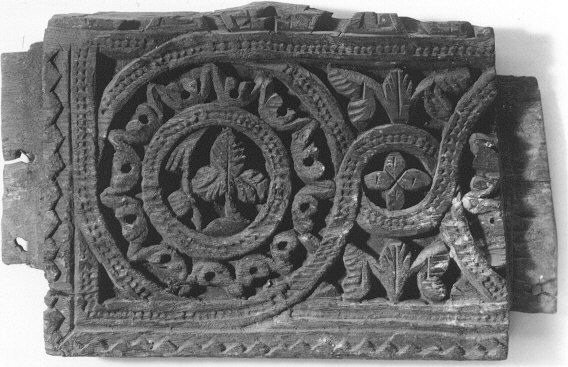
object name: panel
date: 701-900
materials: wood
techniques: carving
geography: iraq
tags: leaves